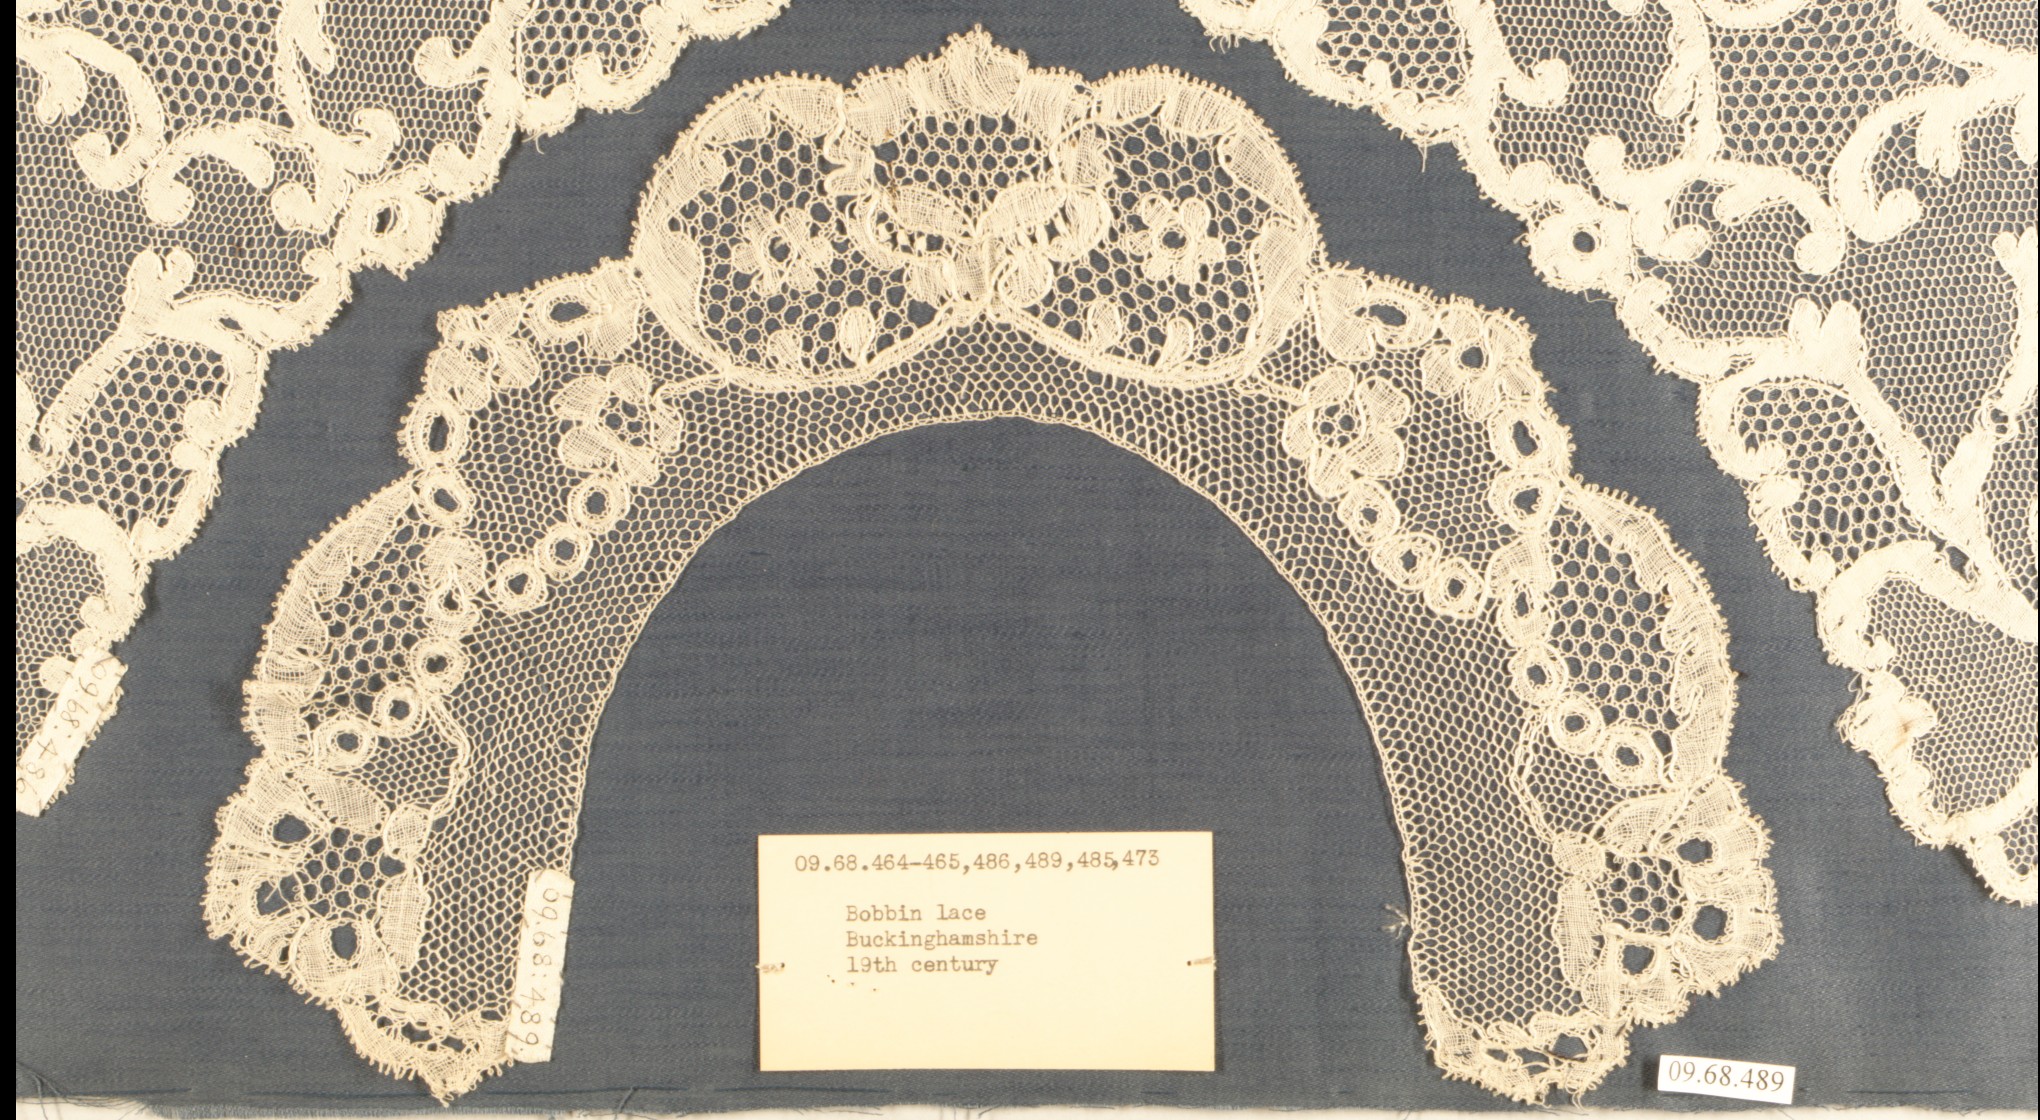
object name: collar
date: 1801-1900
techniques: lace